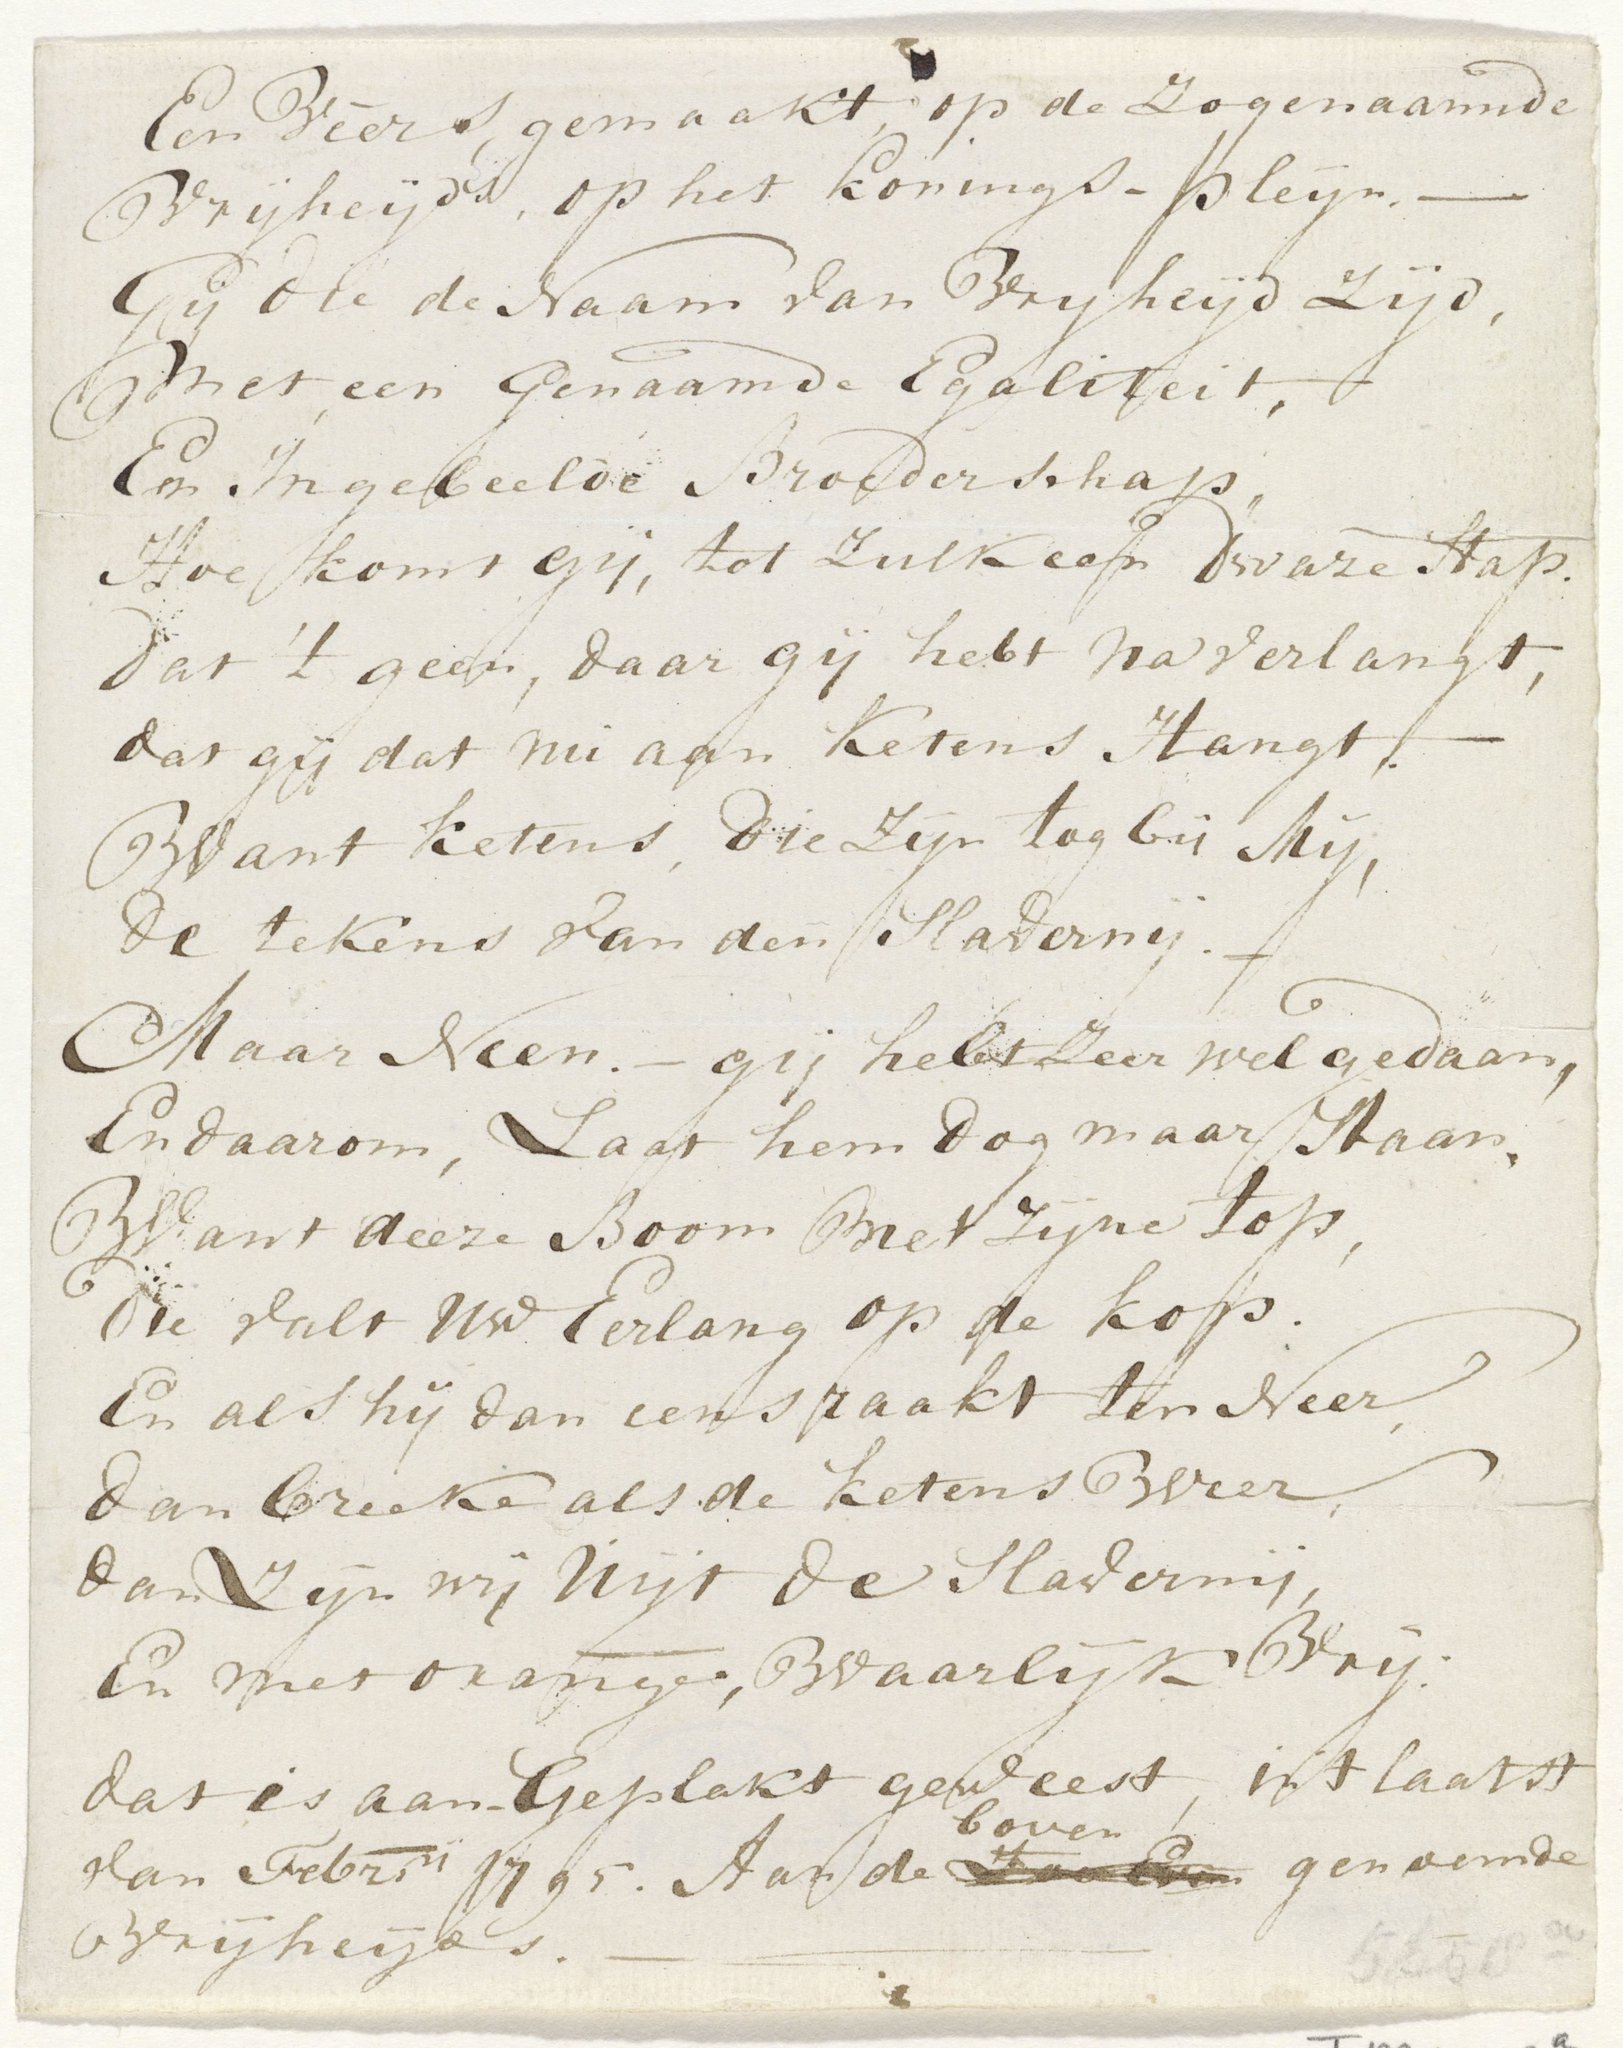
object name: manuscript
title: Een Veers gemaakt, op de zogenaamde Vrijheijds, op het konings-pleijn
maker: Anonymous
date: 1795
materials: paper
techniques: pen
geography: netherlands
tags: koningsplein, vrijheidsfeest te amsterdam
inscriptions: collector's mark: Lugt 2228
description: Handgeschreven transcriptie van een Orangistisch vers van zestien regels, eind februari geplakt op de vrijheidsboom opgericht op het Koningsplein, destijds omgedoopt tot Burgerplein, te Amsterdam.